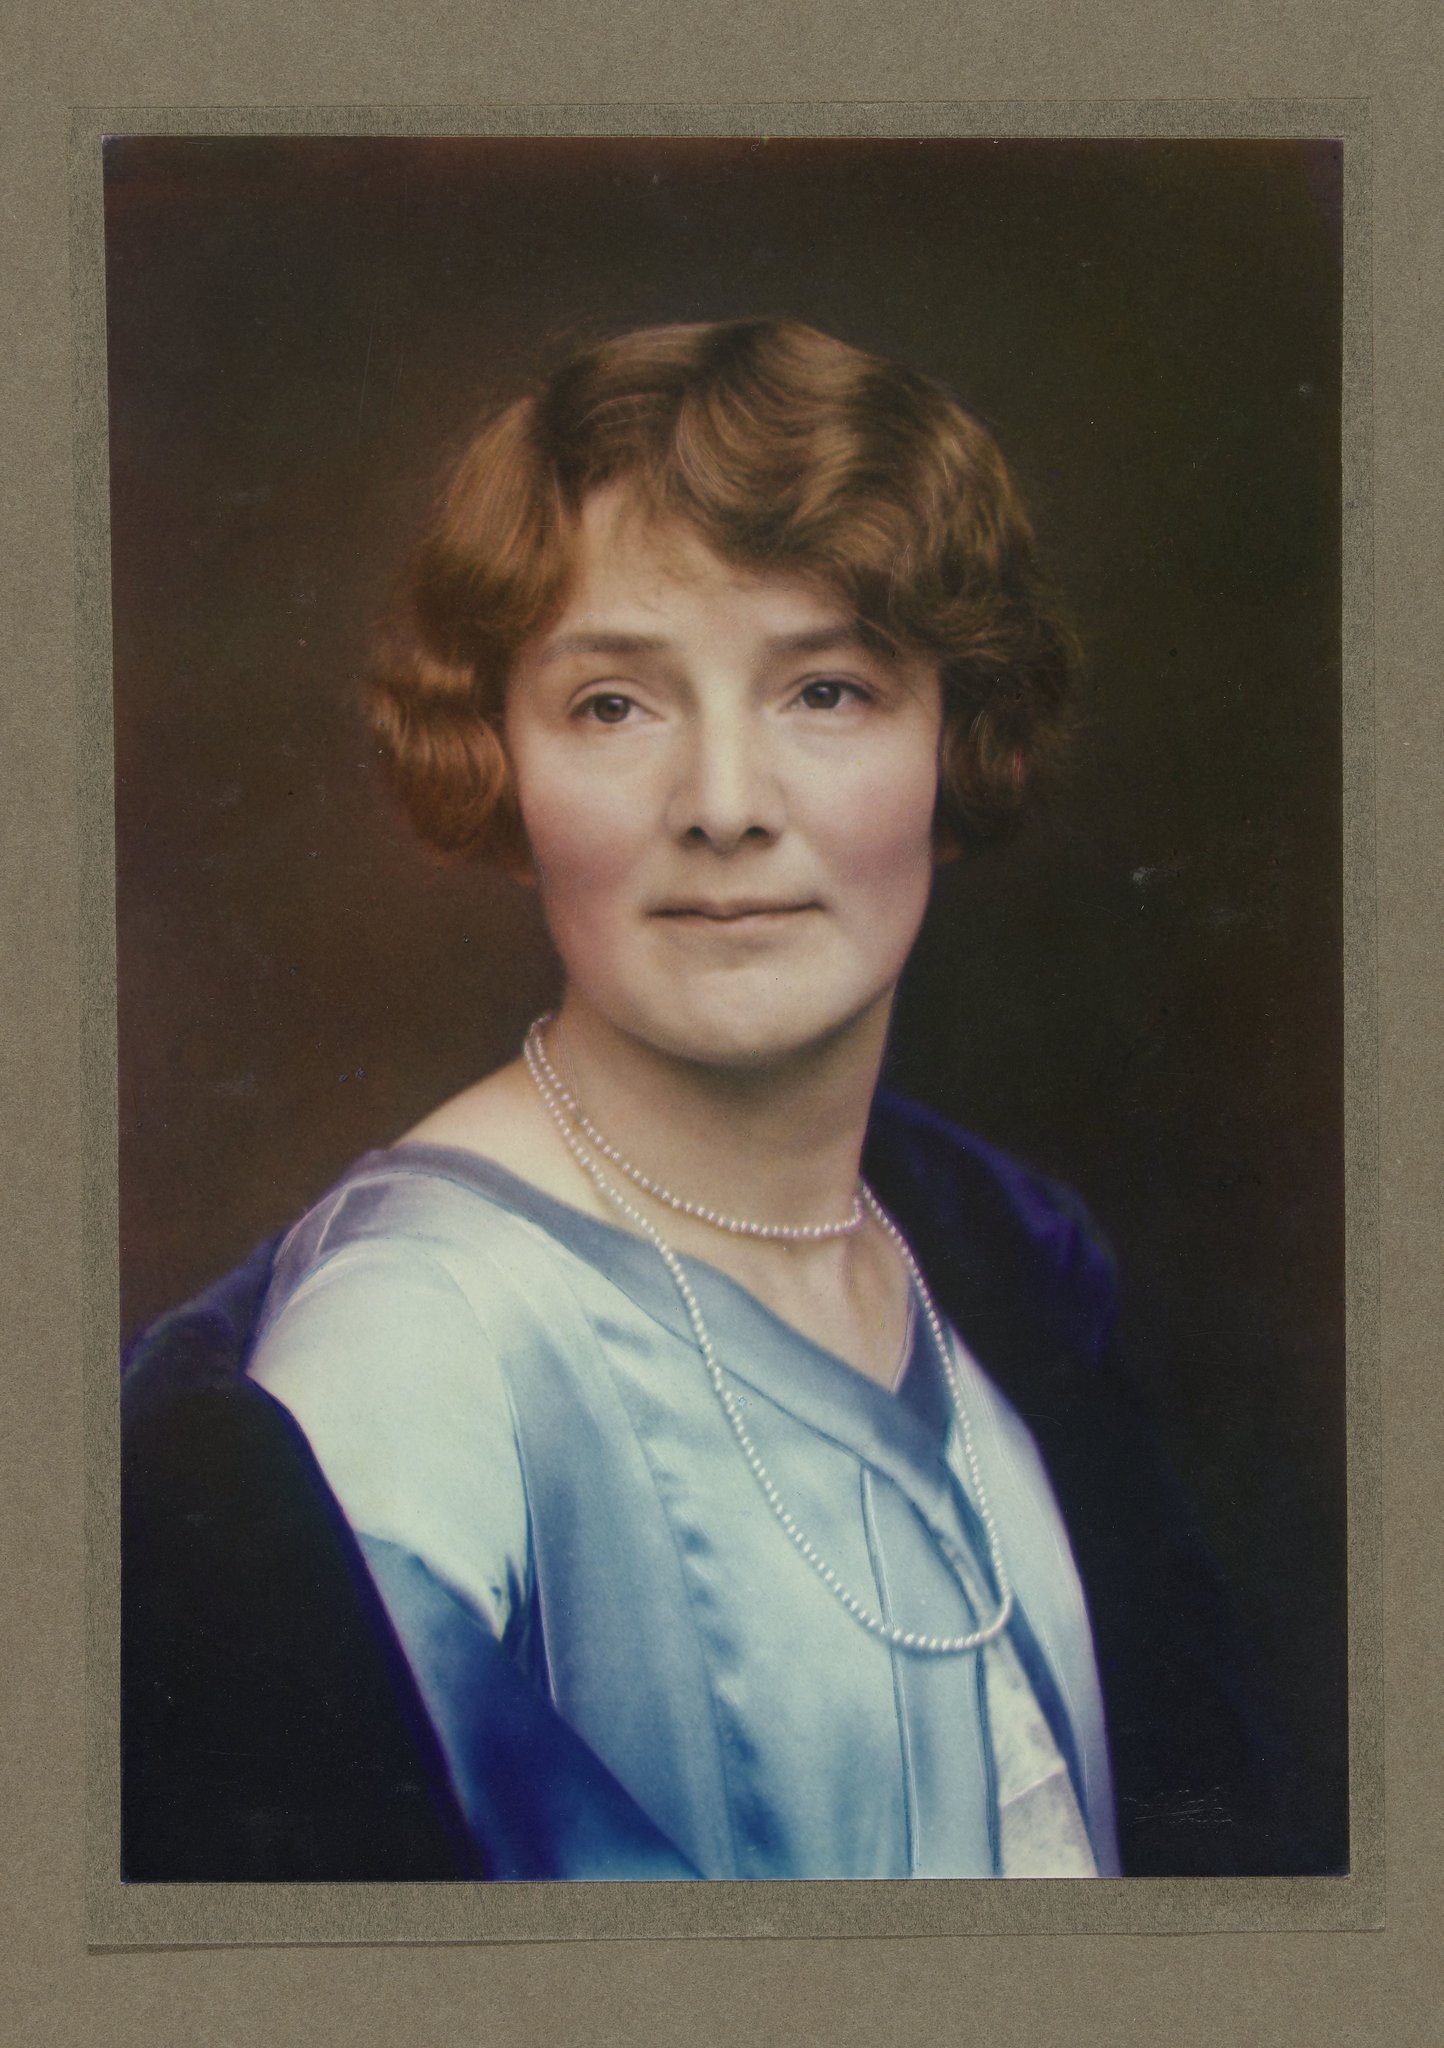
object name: photograph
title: Portret van een vrouw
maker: jacob merkelbach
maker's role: fotograaf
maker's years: 1877-1942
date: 1920-1930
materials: cardboard, photographic support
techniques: jos-pé print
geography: amsterdam